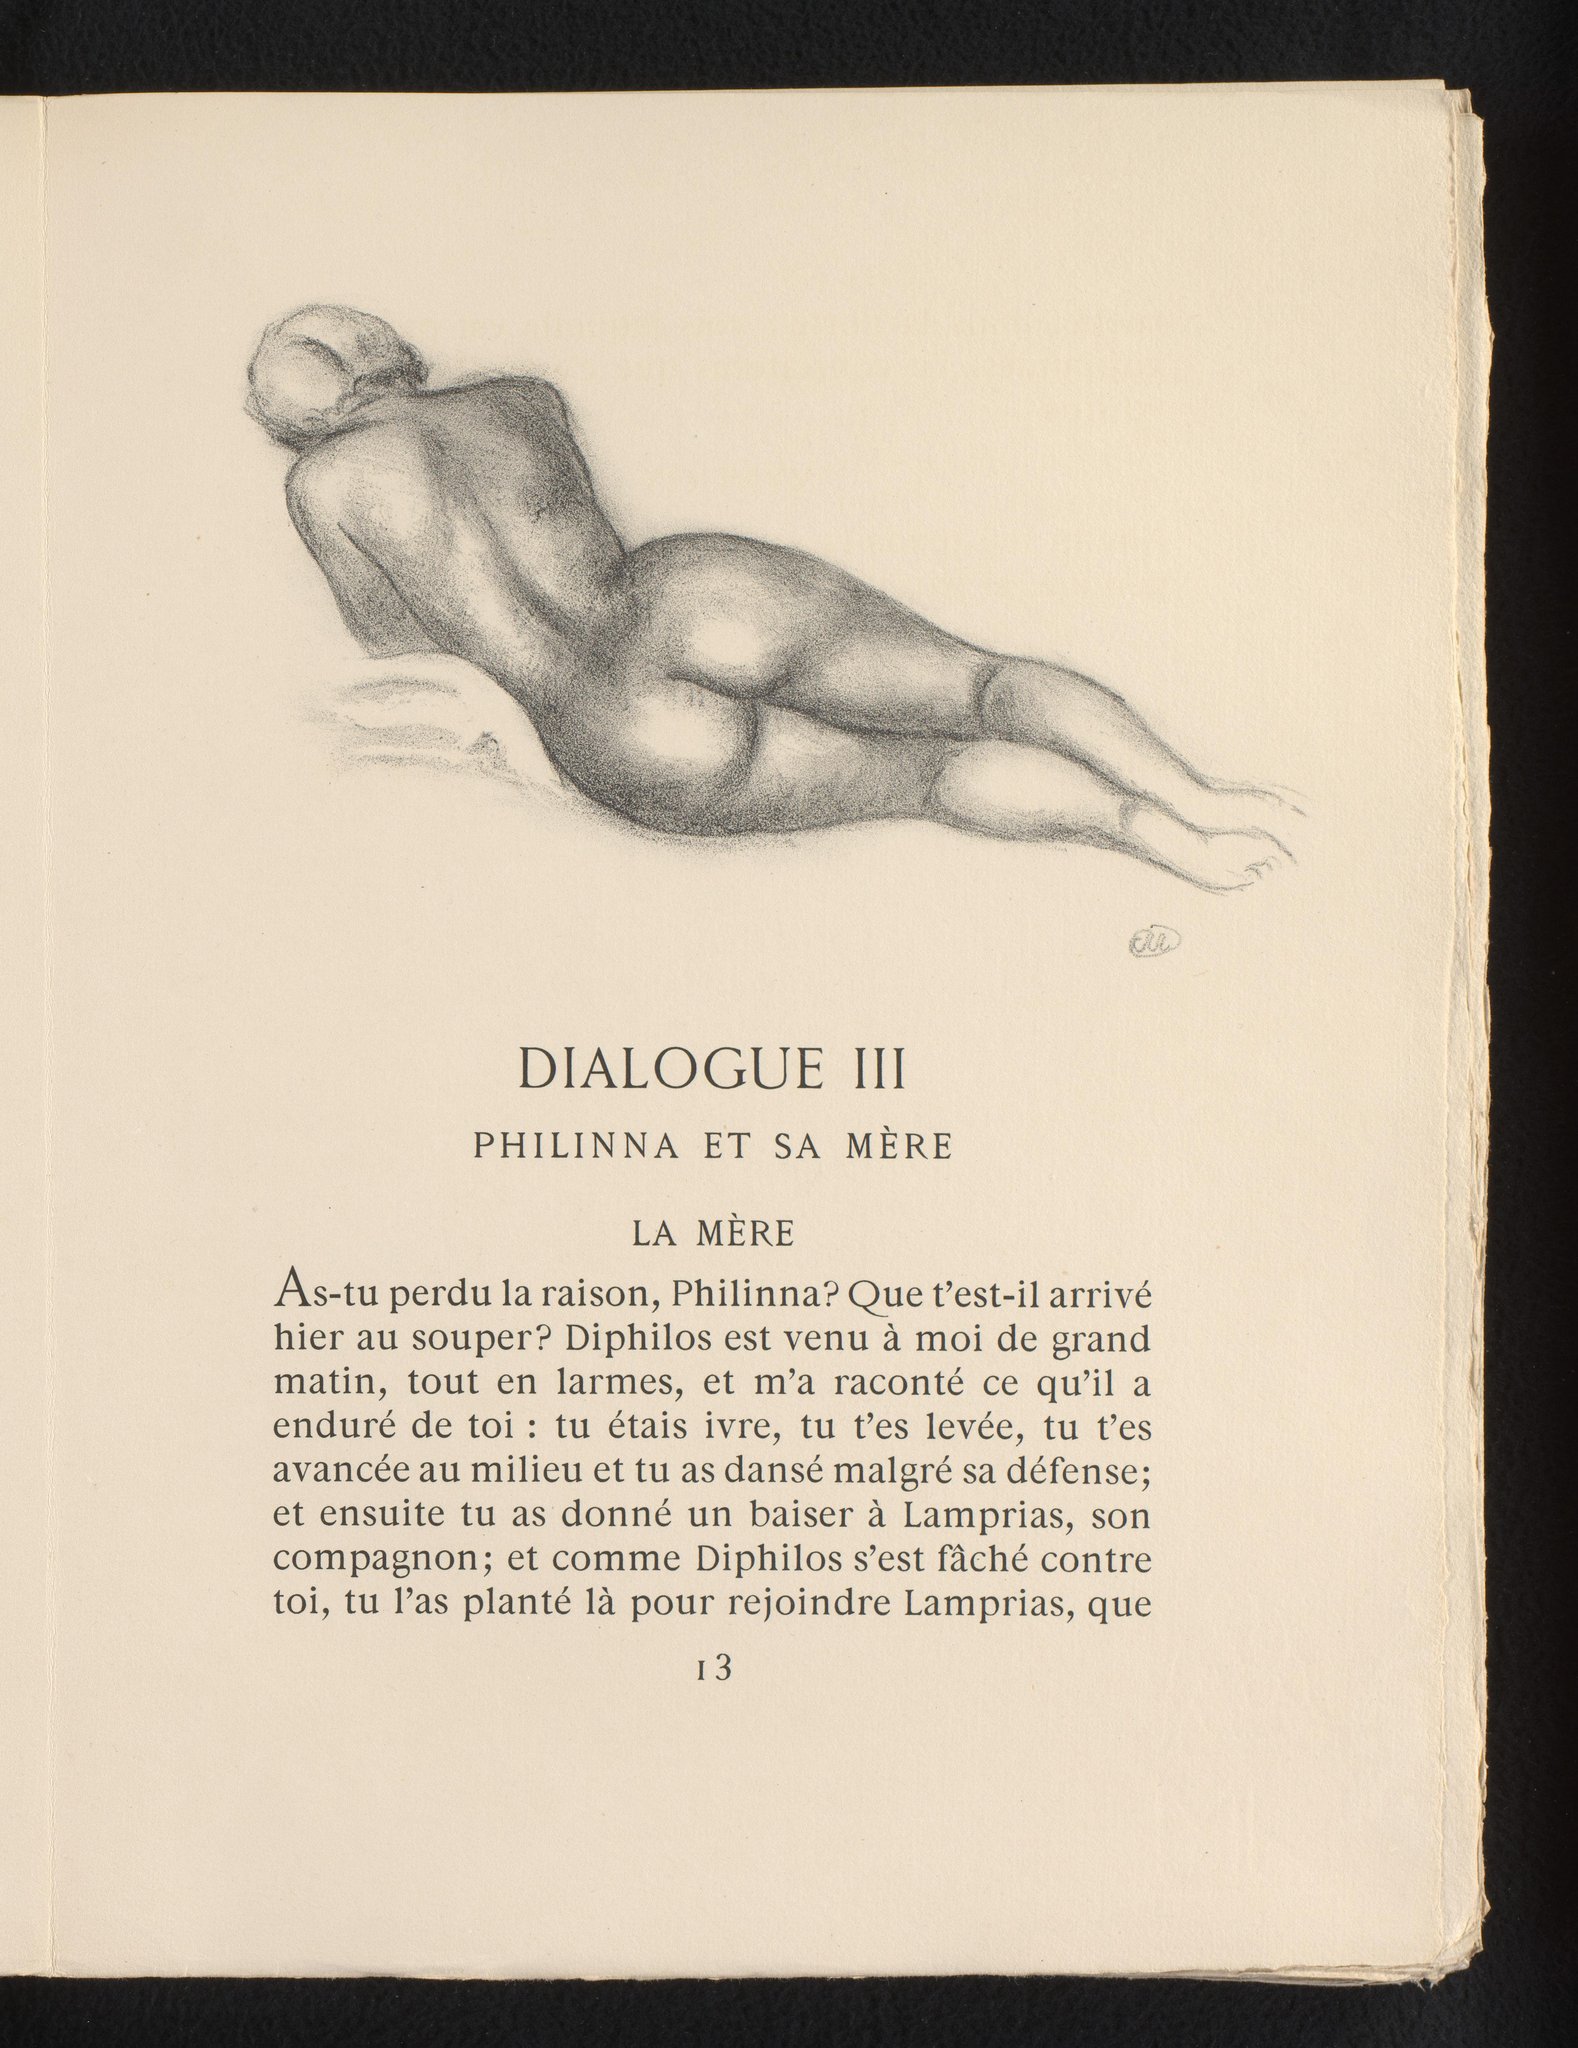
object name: book illustration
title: Liggende naakte vrouw, op de rug gezien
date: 1948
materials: paper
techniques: letterpress printing, lithograph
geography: paris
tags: lying on one side, with uplifted upper part of the body and leaning on the arm - aa - female human figure, woman (showing herself) undressed, quasi-nude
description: Prent uit: Lucianus van Samosata. Dialogues des Courtisanes. [Vertaald uit het Grieks door] Charles Astruc. Parijs: s.n., 1948, p. 13.